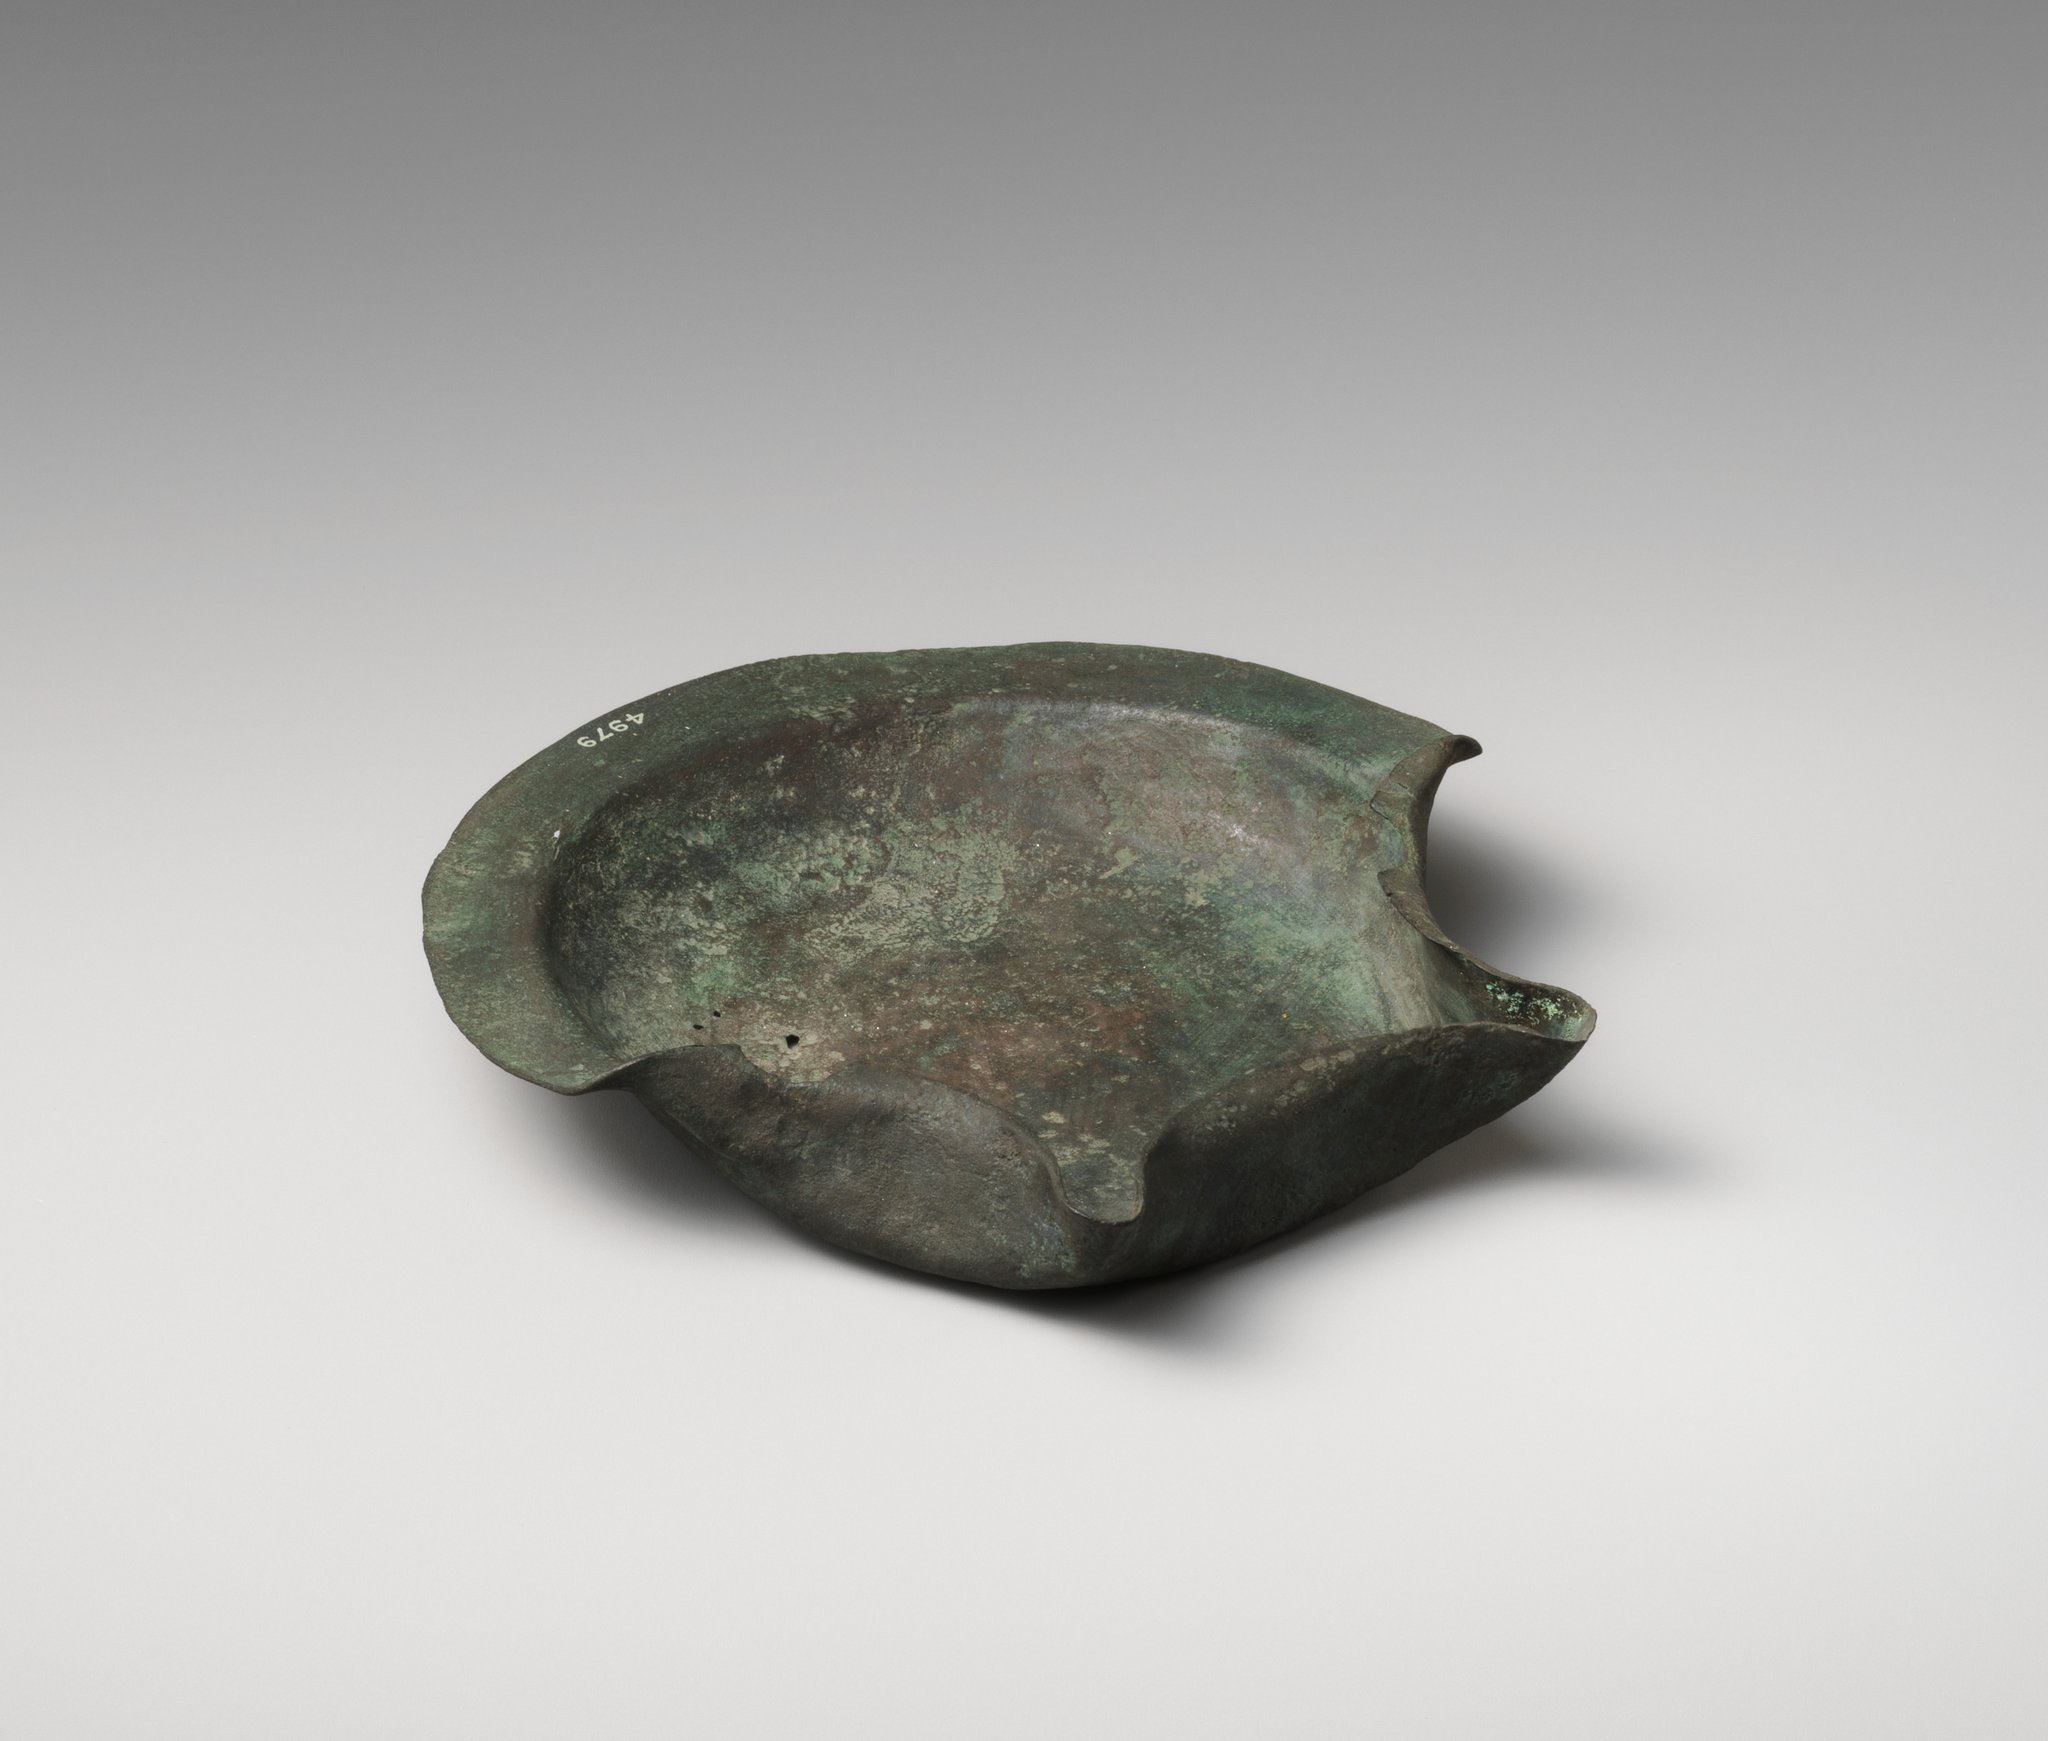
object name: lamp, saucer shaped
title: Bronze saucer-shaped lamp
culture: cypriot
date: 600-401 BCE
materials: bronze